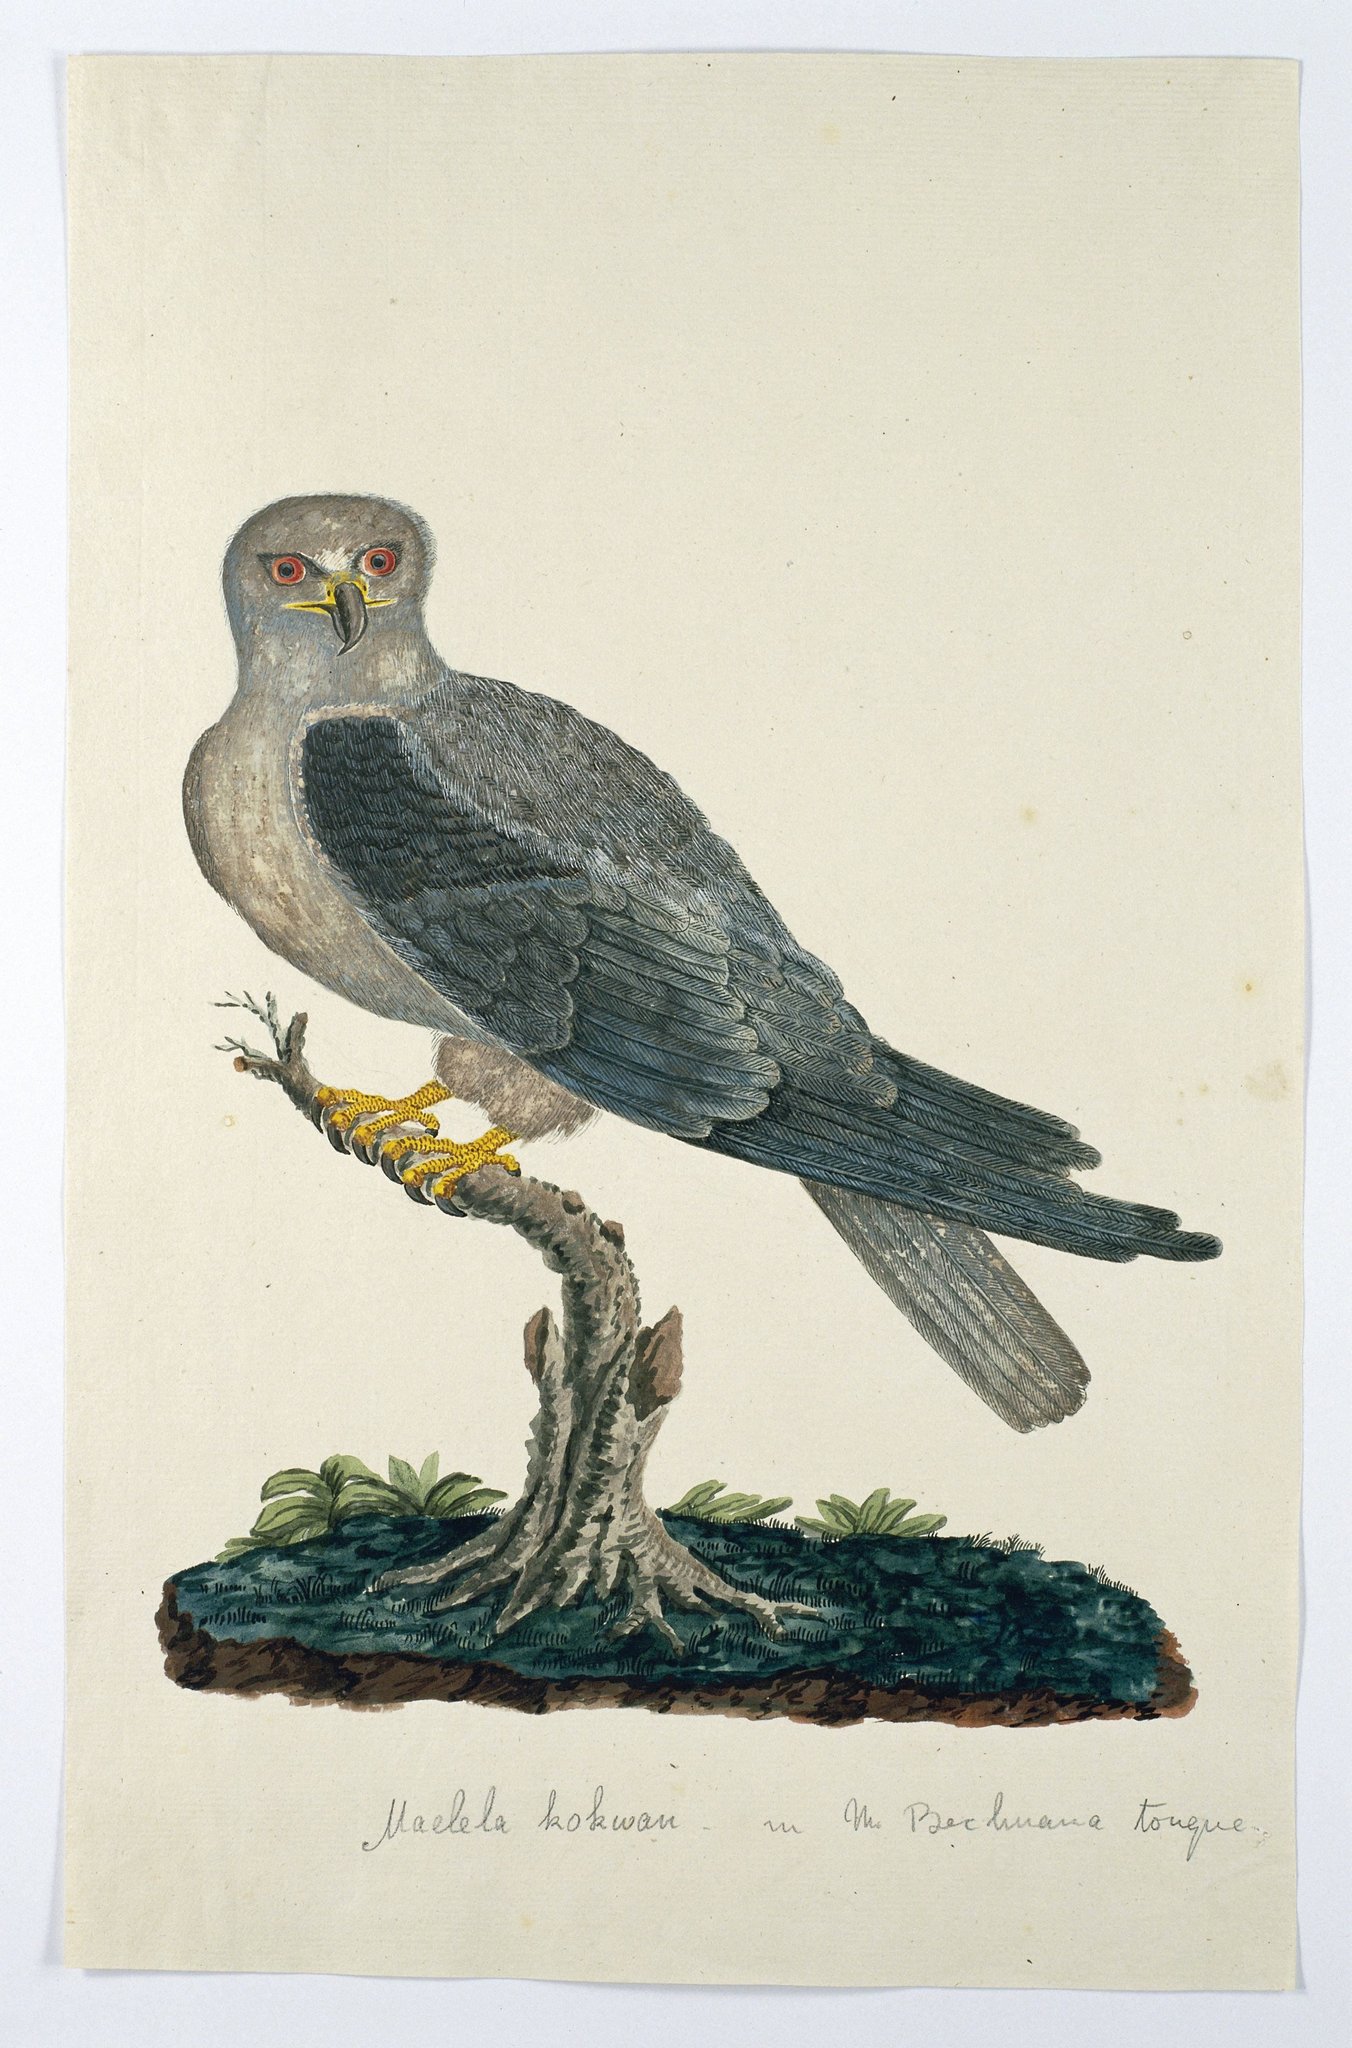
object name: album leaf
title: Elanus caeruleus (Black-winged kite)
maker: robert jacob gordon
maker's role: draughtsman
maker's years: 1743-1795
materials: chalk, ink, paper, pencil, watercolor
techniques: brush, pen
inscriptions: annotation: ‘Maelela kokwan - in the Bechuana tongue.’